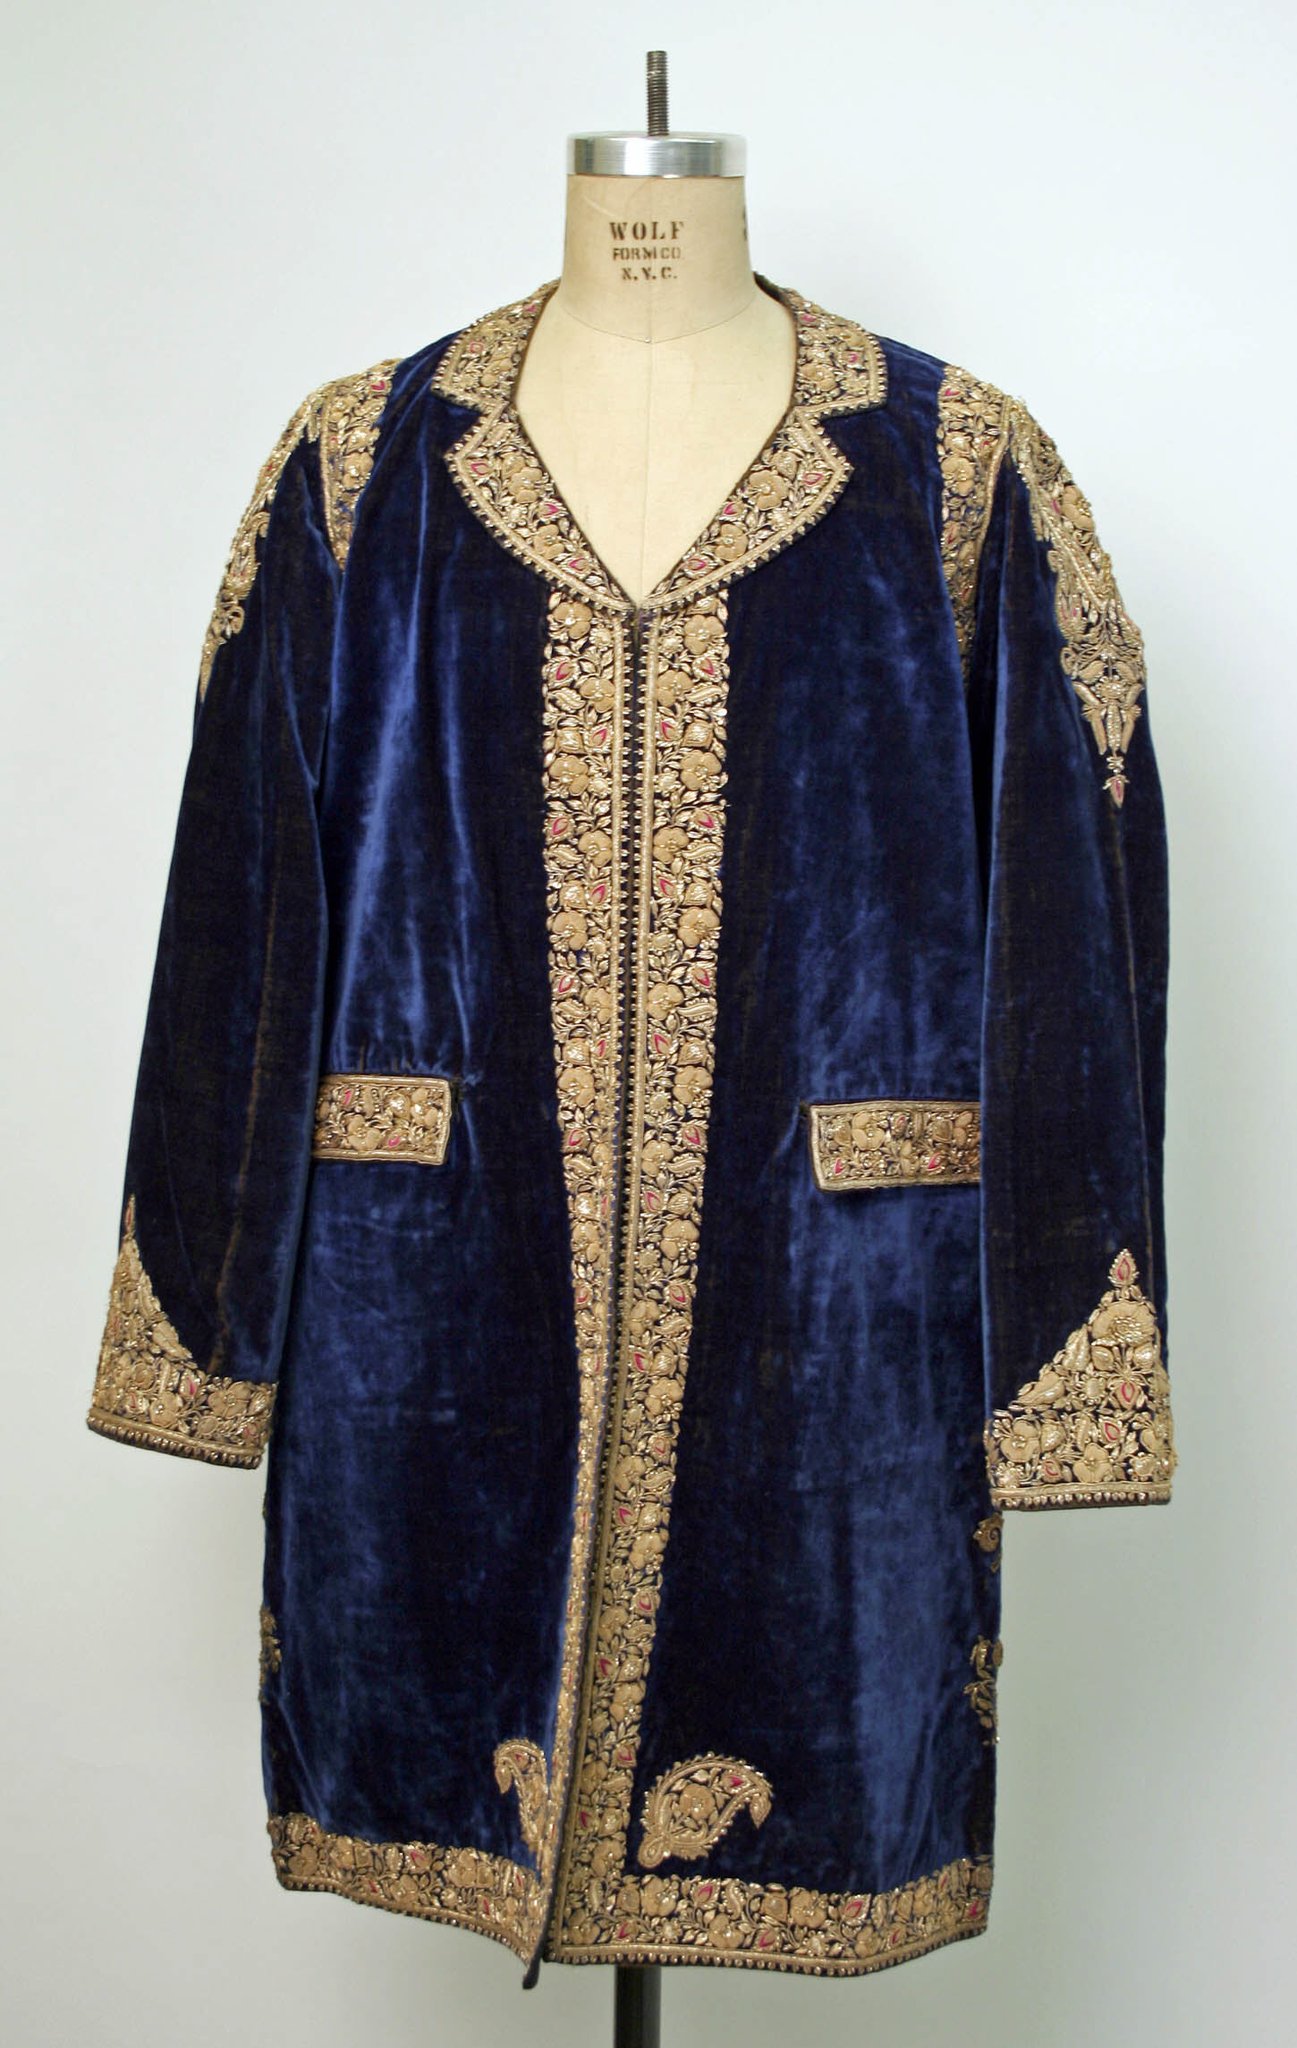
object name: coat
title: Choga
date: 1867-1900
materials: metal thread, silk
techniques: embroidery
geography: india